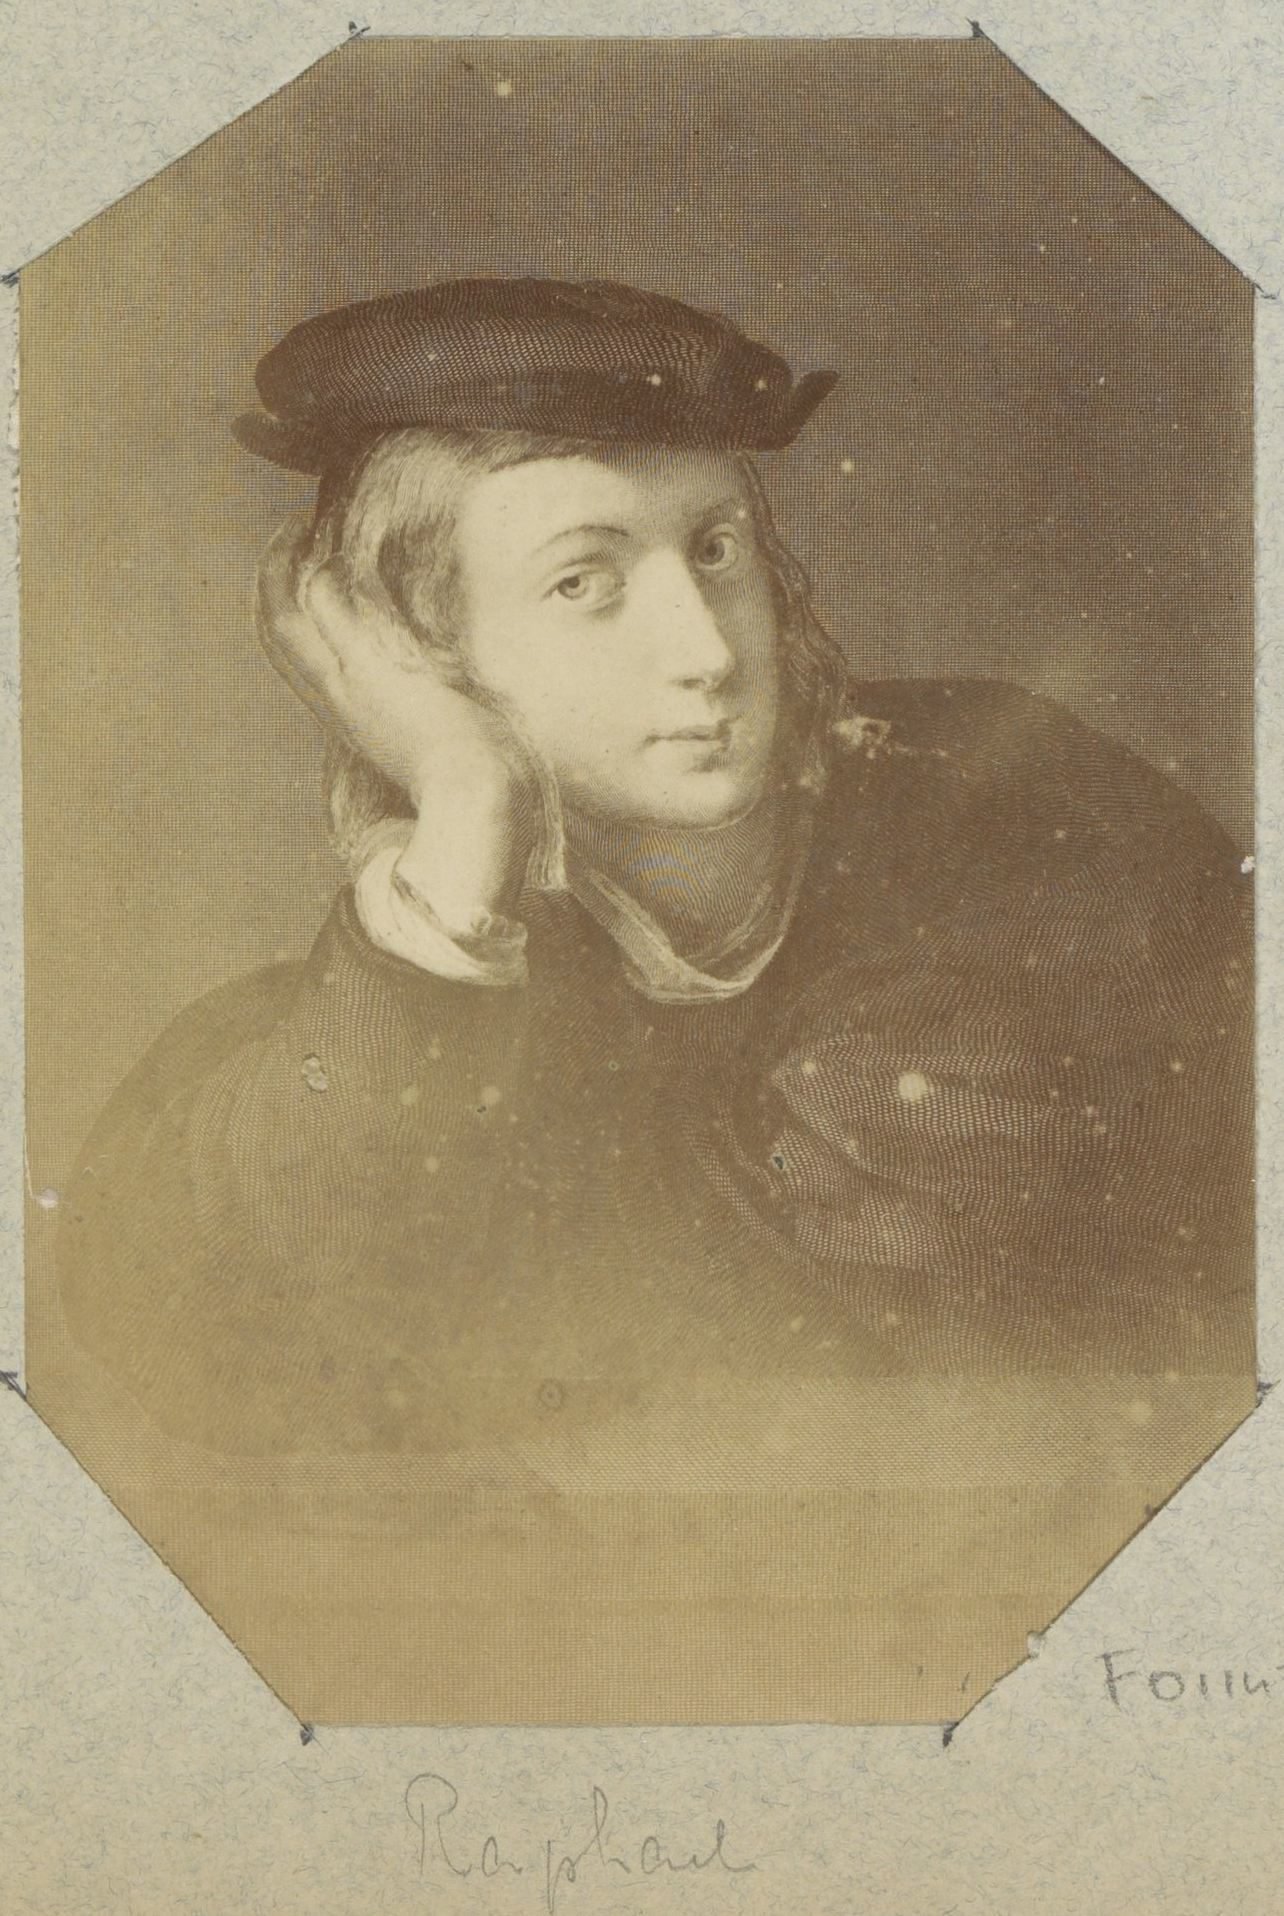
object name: album leaf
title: Fotoreproductie van (vermoedelijk) een prent van een jongeman, mogelijk naar een schilderij van Rafaël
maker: Anonymous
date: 1880-1900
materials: paper, photographic support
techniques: albumen print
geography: france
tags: youth, adolescent, france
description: Onderdeel van Album van een Franse amateur met foto's van Frankrijk, Algerije, Palmyra, de Wereldtentoonstelling van 1900 en van bekende Fransen.